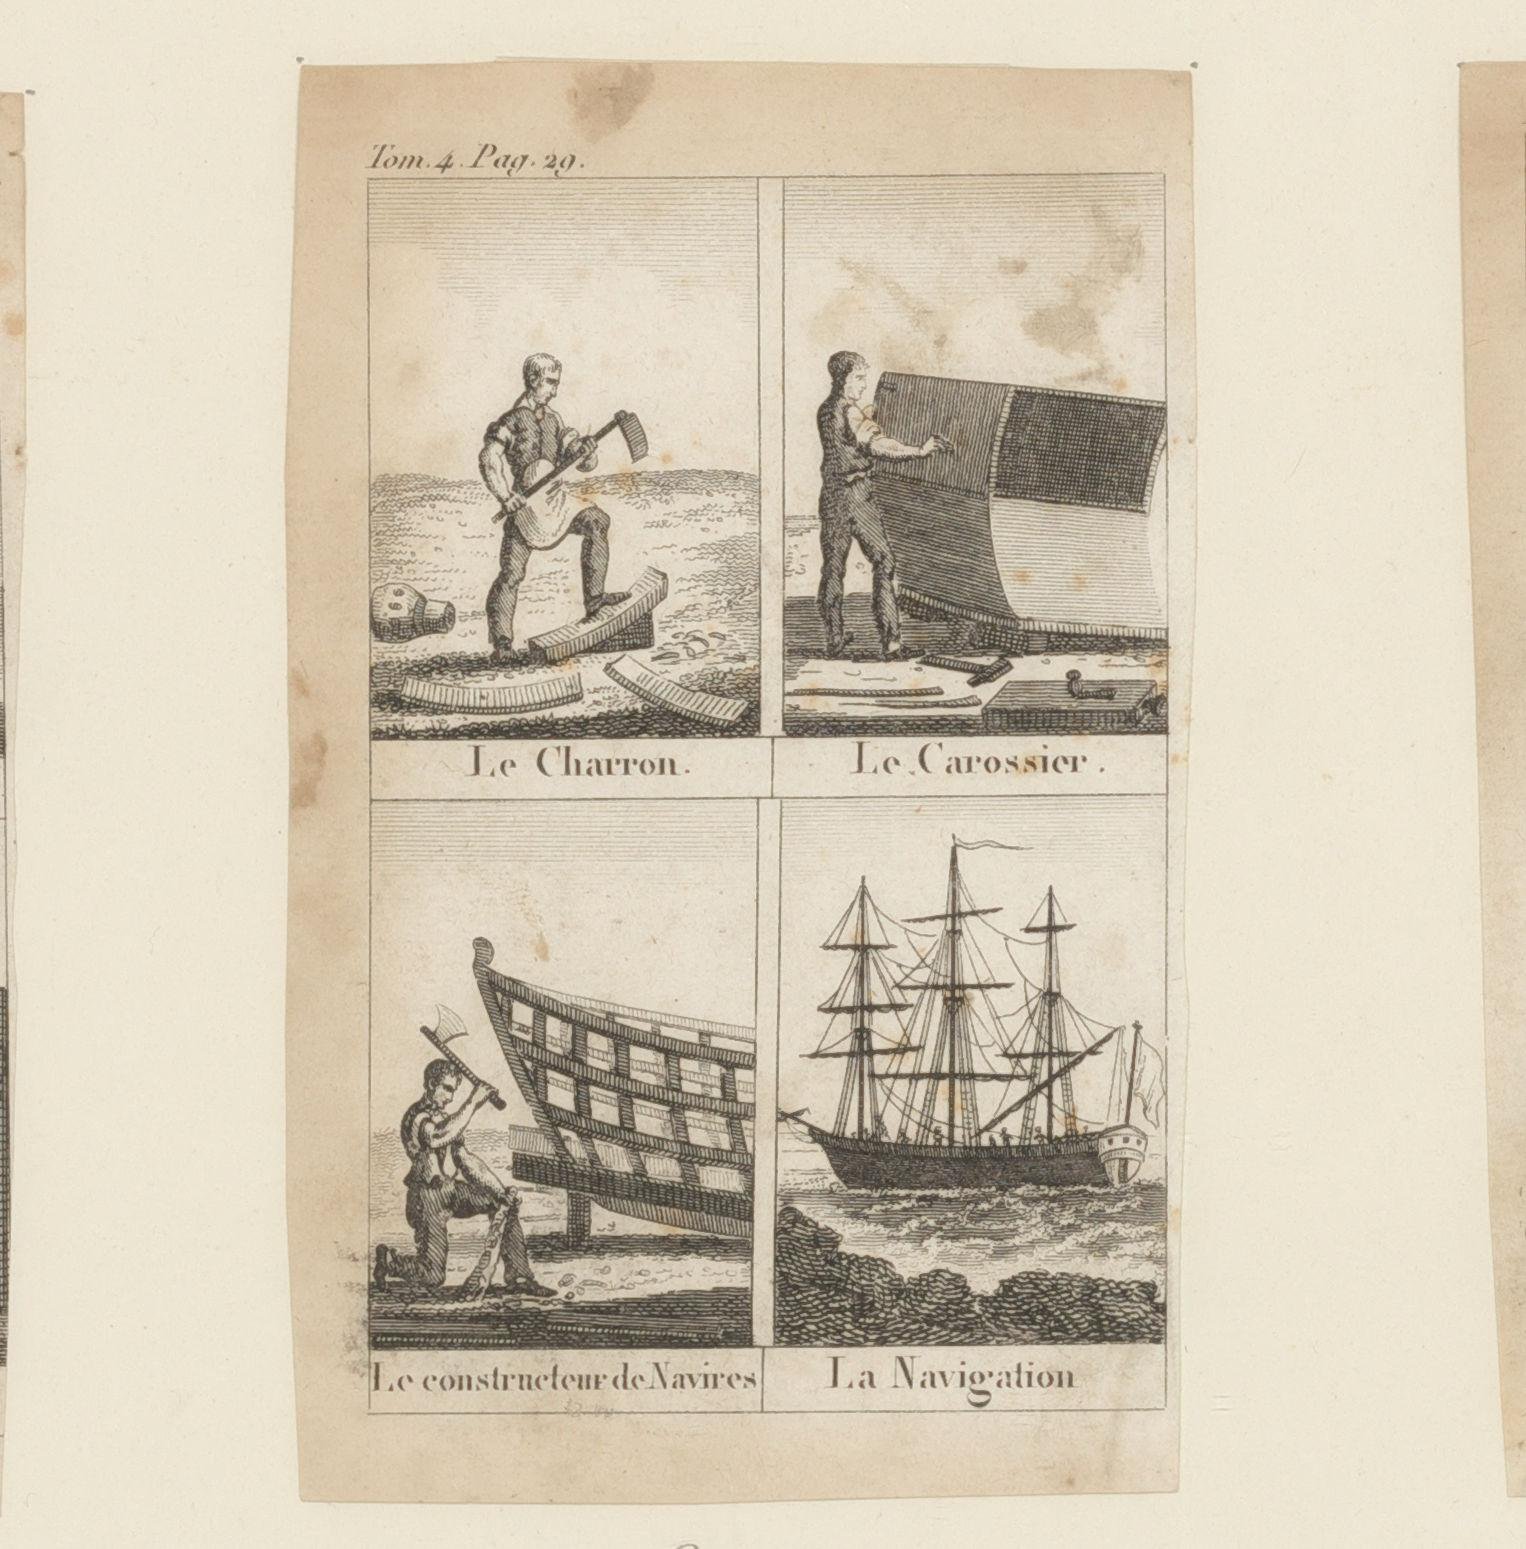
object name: print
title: Wagenmaker, koetsenmaker, scheepsmaker, de navigator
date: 1816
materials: paper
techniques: etching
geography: paris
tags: ship's carpenter, handicrafts, craftsman at work, building a ship, ship under construction, shipyard-workers, handicrafts and industries, handicrafts ~ wood, timber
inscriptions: stamp, collector's mark: Lugt 1641, collector's mark: Lugt 1641a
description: Vier voorstellingen van beroepen en bedrijven: De wagenmaker, koetsenmaker, scheepsmaker, de navigator. Bovenaan genummerd: Tom. 4. Pag. 29. Onderwerpsrubrieken binnen de Atlas Zeden en Gewoonten: Handel, Nijverheid en Verkeer, Beroep en Bedrijf, Mannelijk, Complete suites.